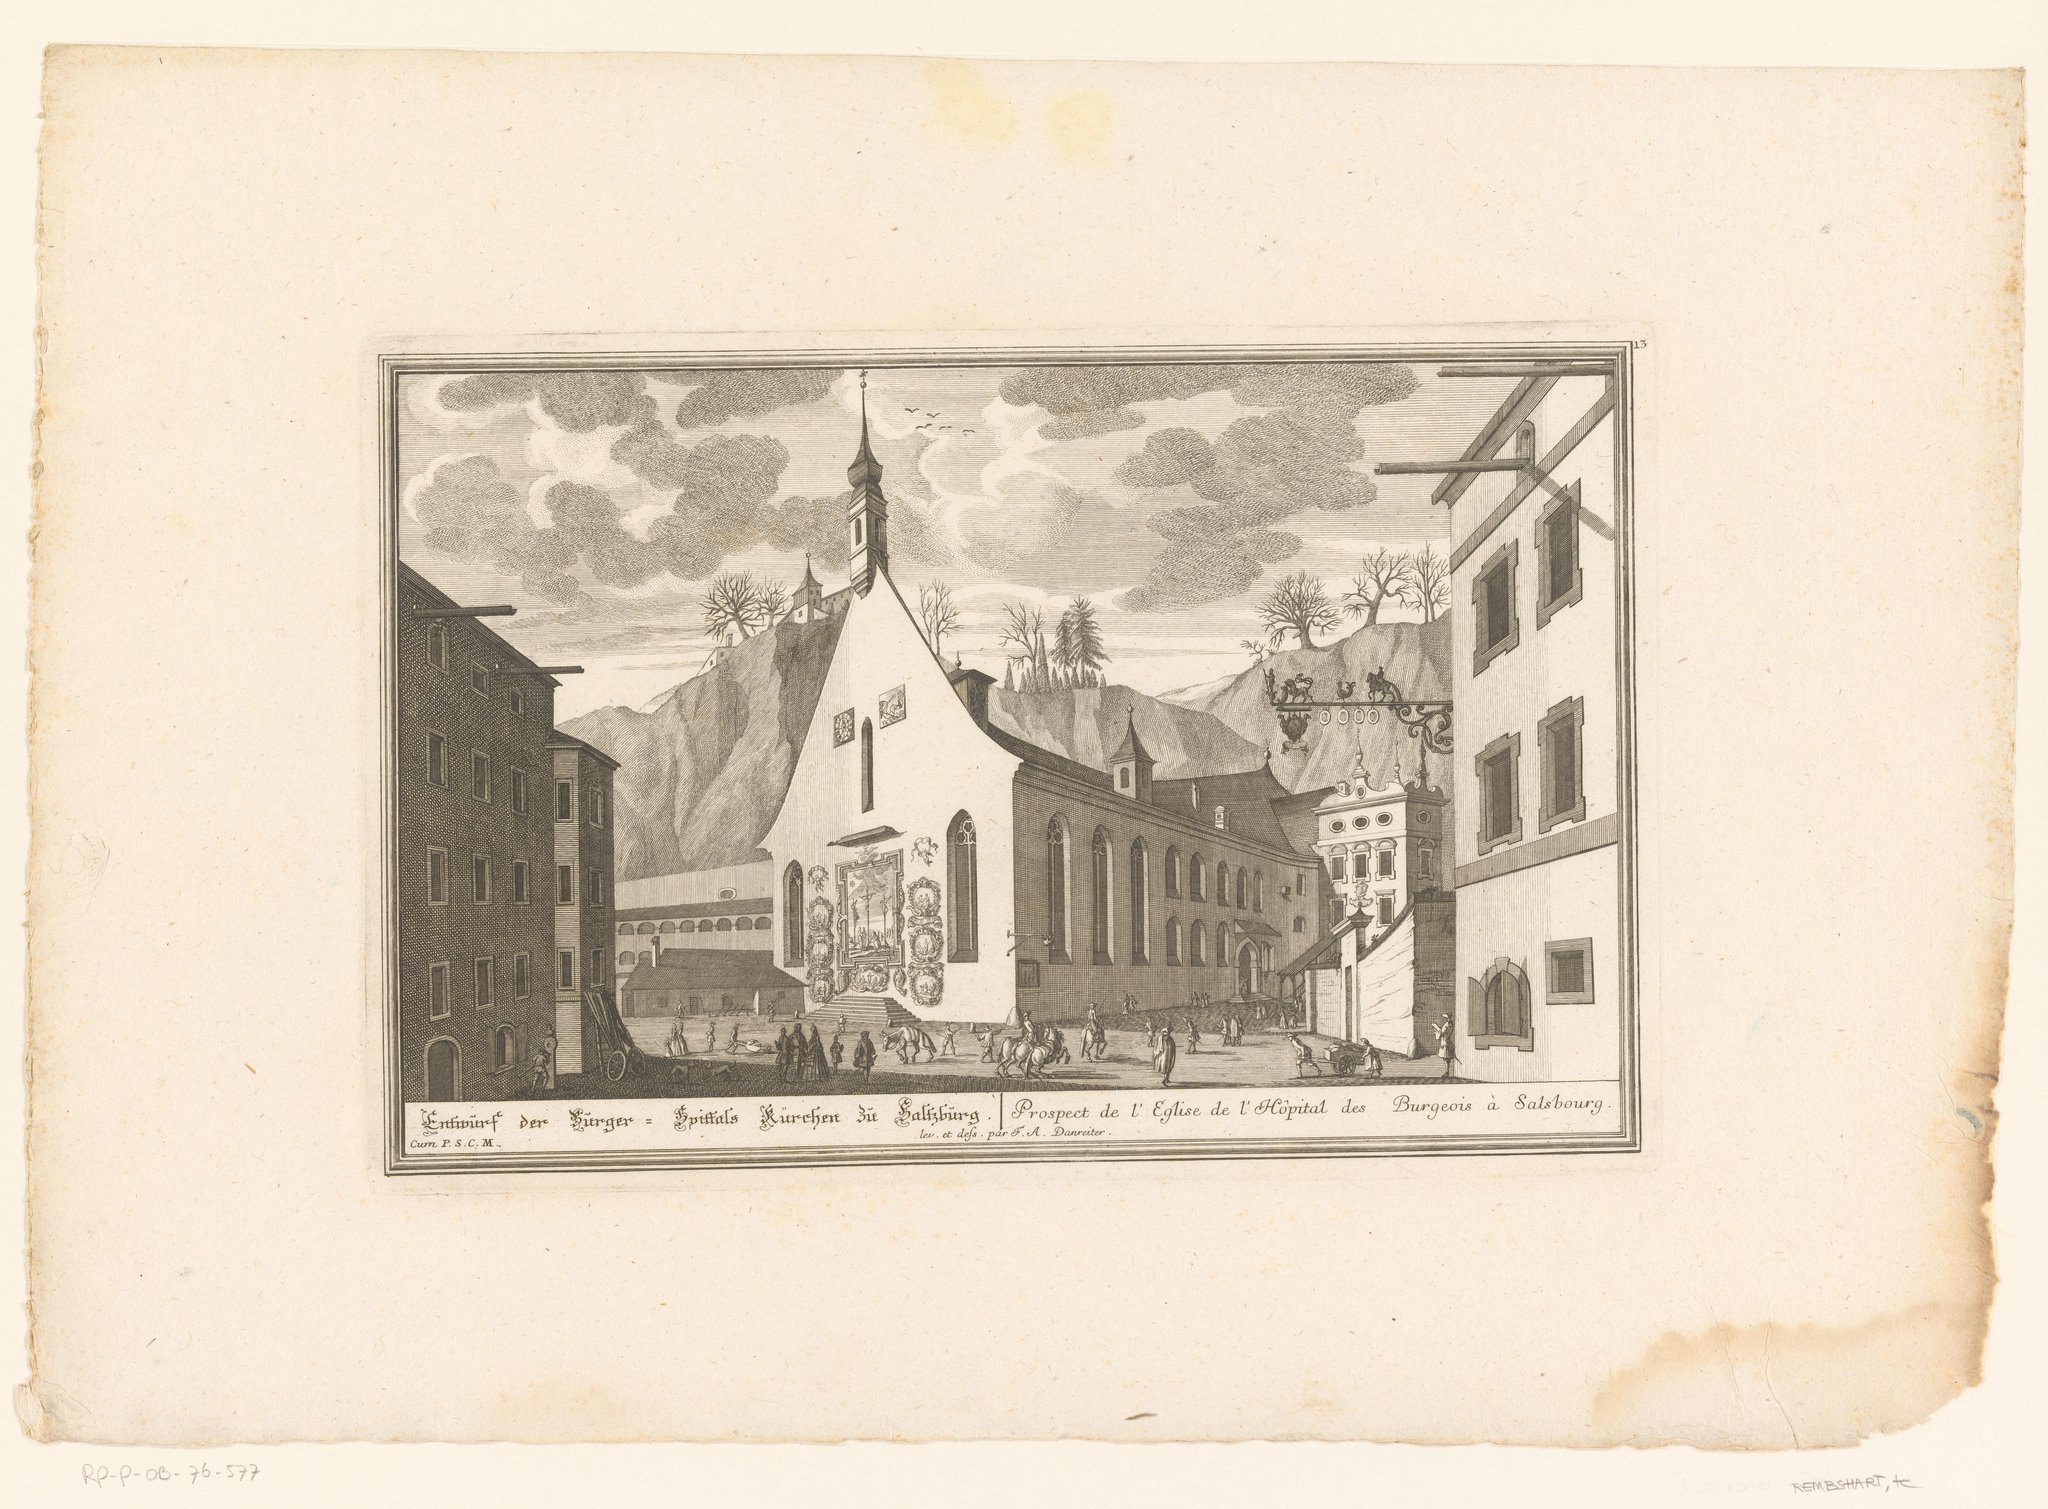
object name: print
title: Sint Blasiuskerk in Salzburg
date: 1730-1740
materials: paper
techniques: engraving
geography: augsburg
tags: parts of church exterior and annexes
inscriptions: collector's mark: Lugt 2228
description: Façade en zijde van de Sint Blasiuskerk (de Bürgerspitalkirche) en de Bürgerspitalplatz in Salzburg.